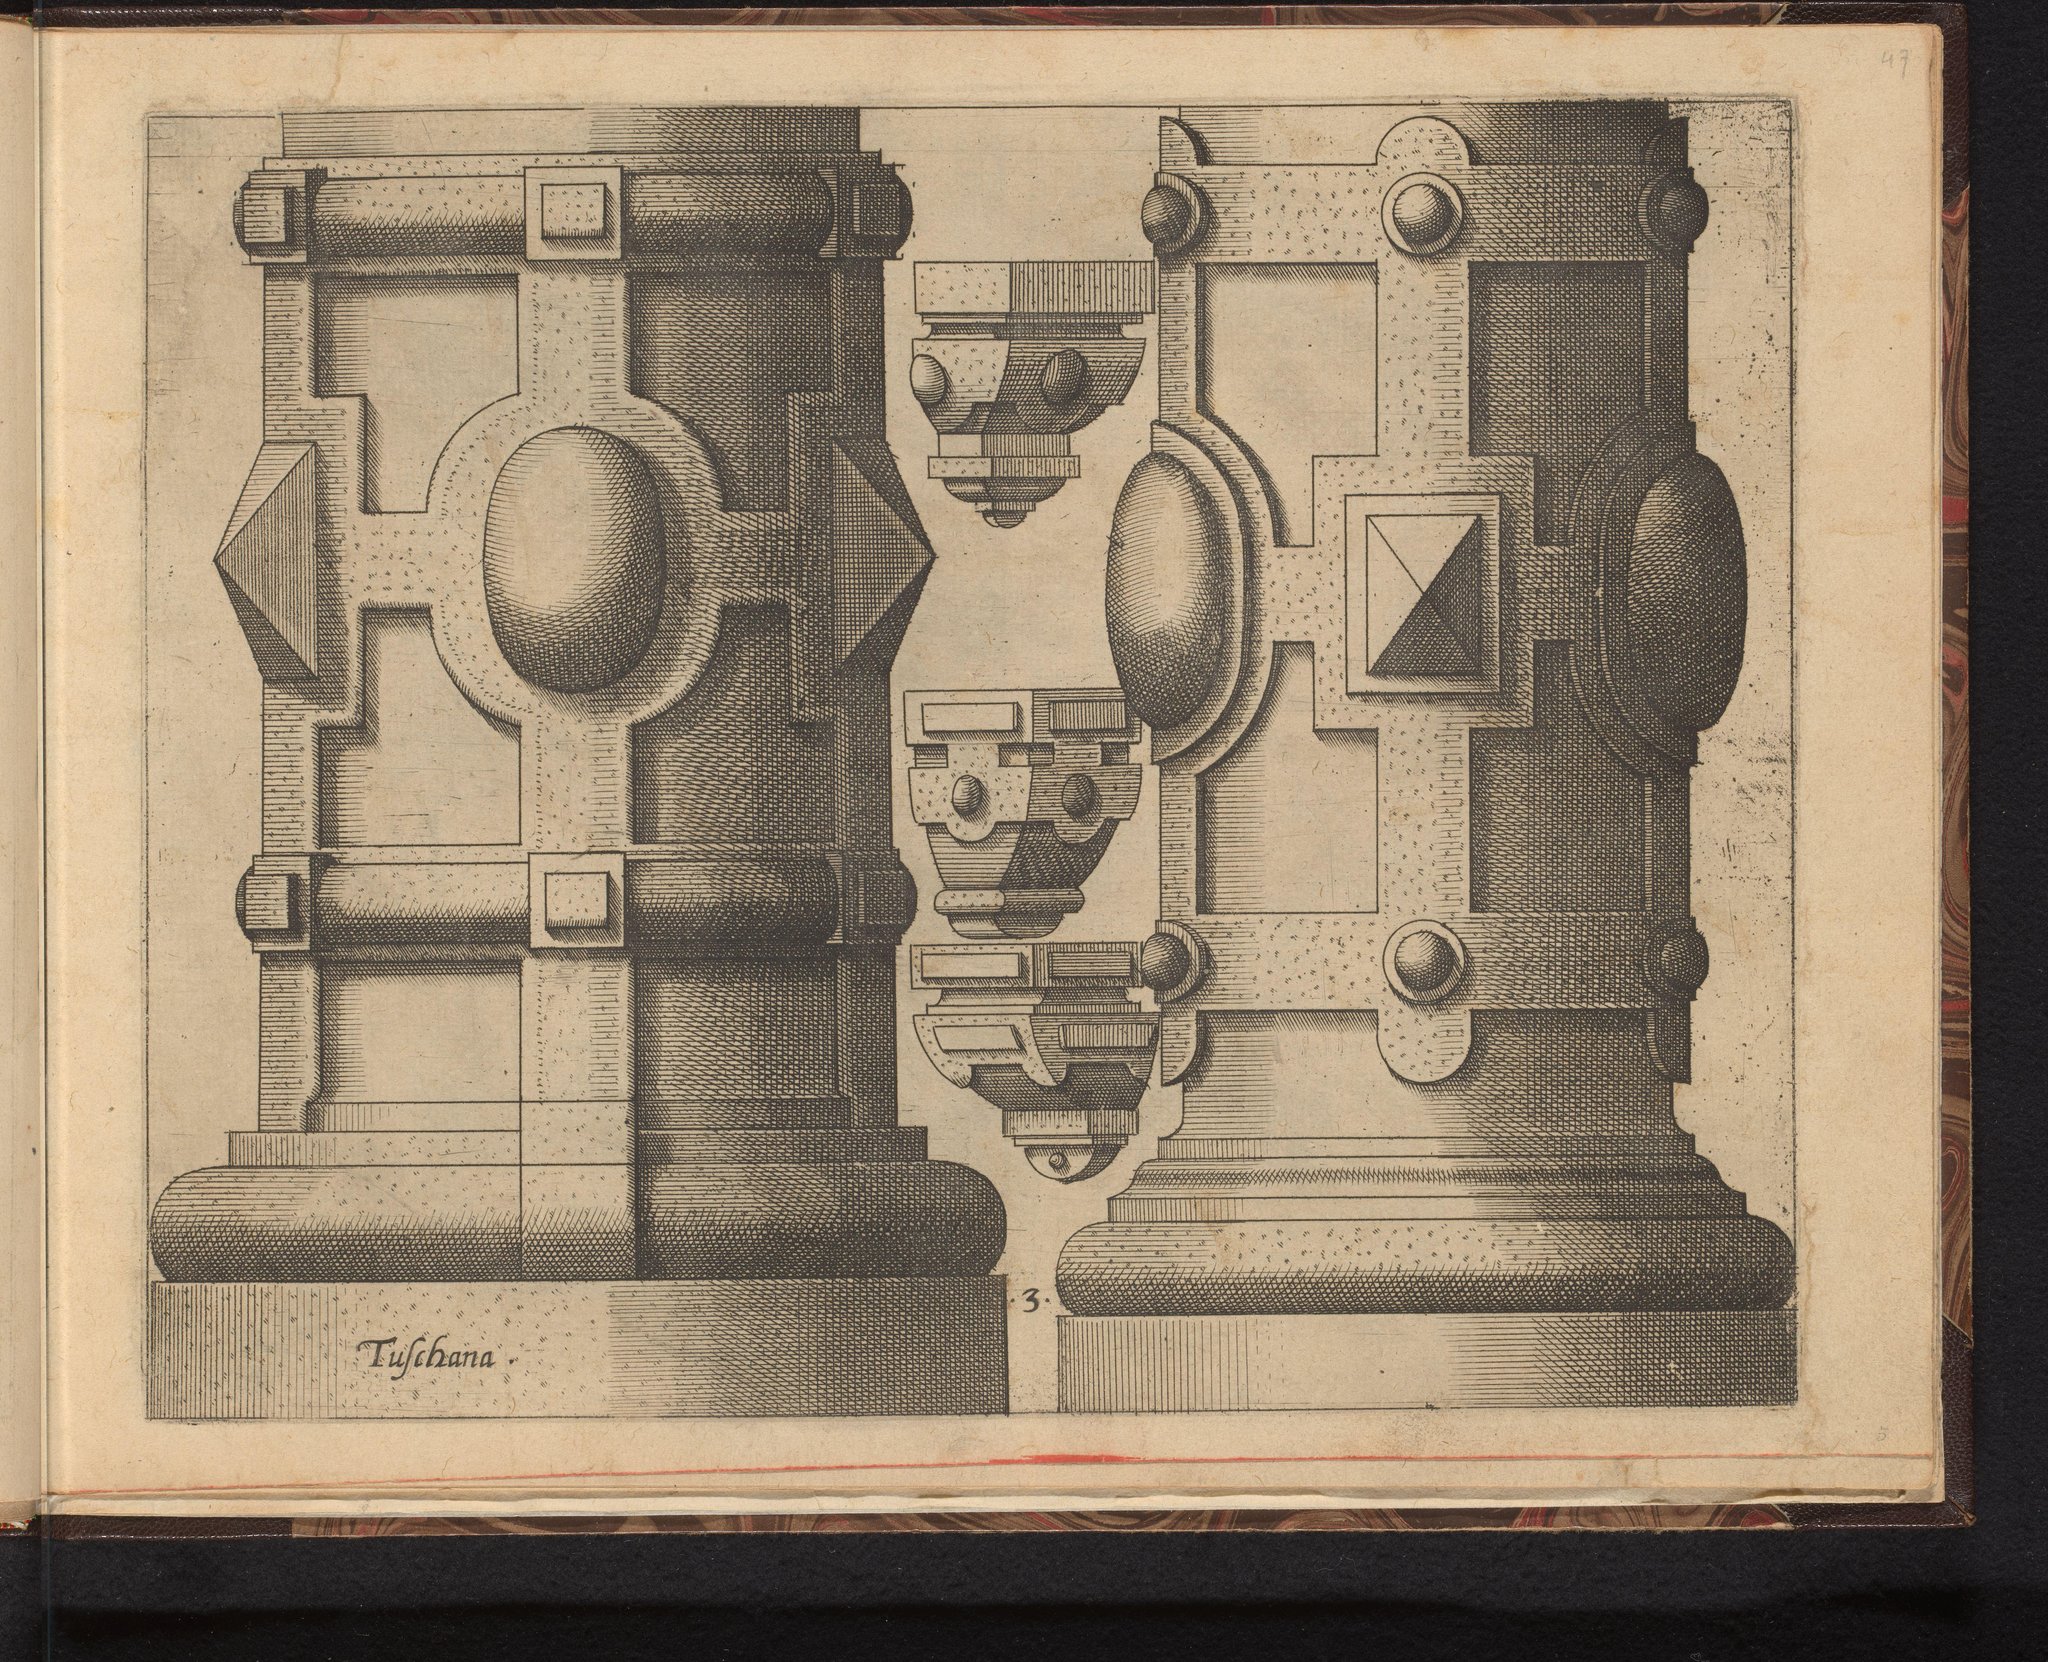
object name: album leaf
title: Architectura de Oorden Tusschana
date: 1578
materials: paper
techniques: etching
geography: antwerp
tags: column, pillar ~ architecture, tuscan order ~ architecture, other architectural details (console)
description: Twee 'columnae caelatae' met rustica, diamantkoppen en halve bollen. Daarbij drie consoles. De prent maakt deel uit van een album.